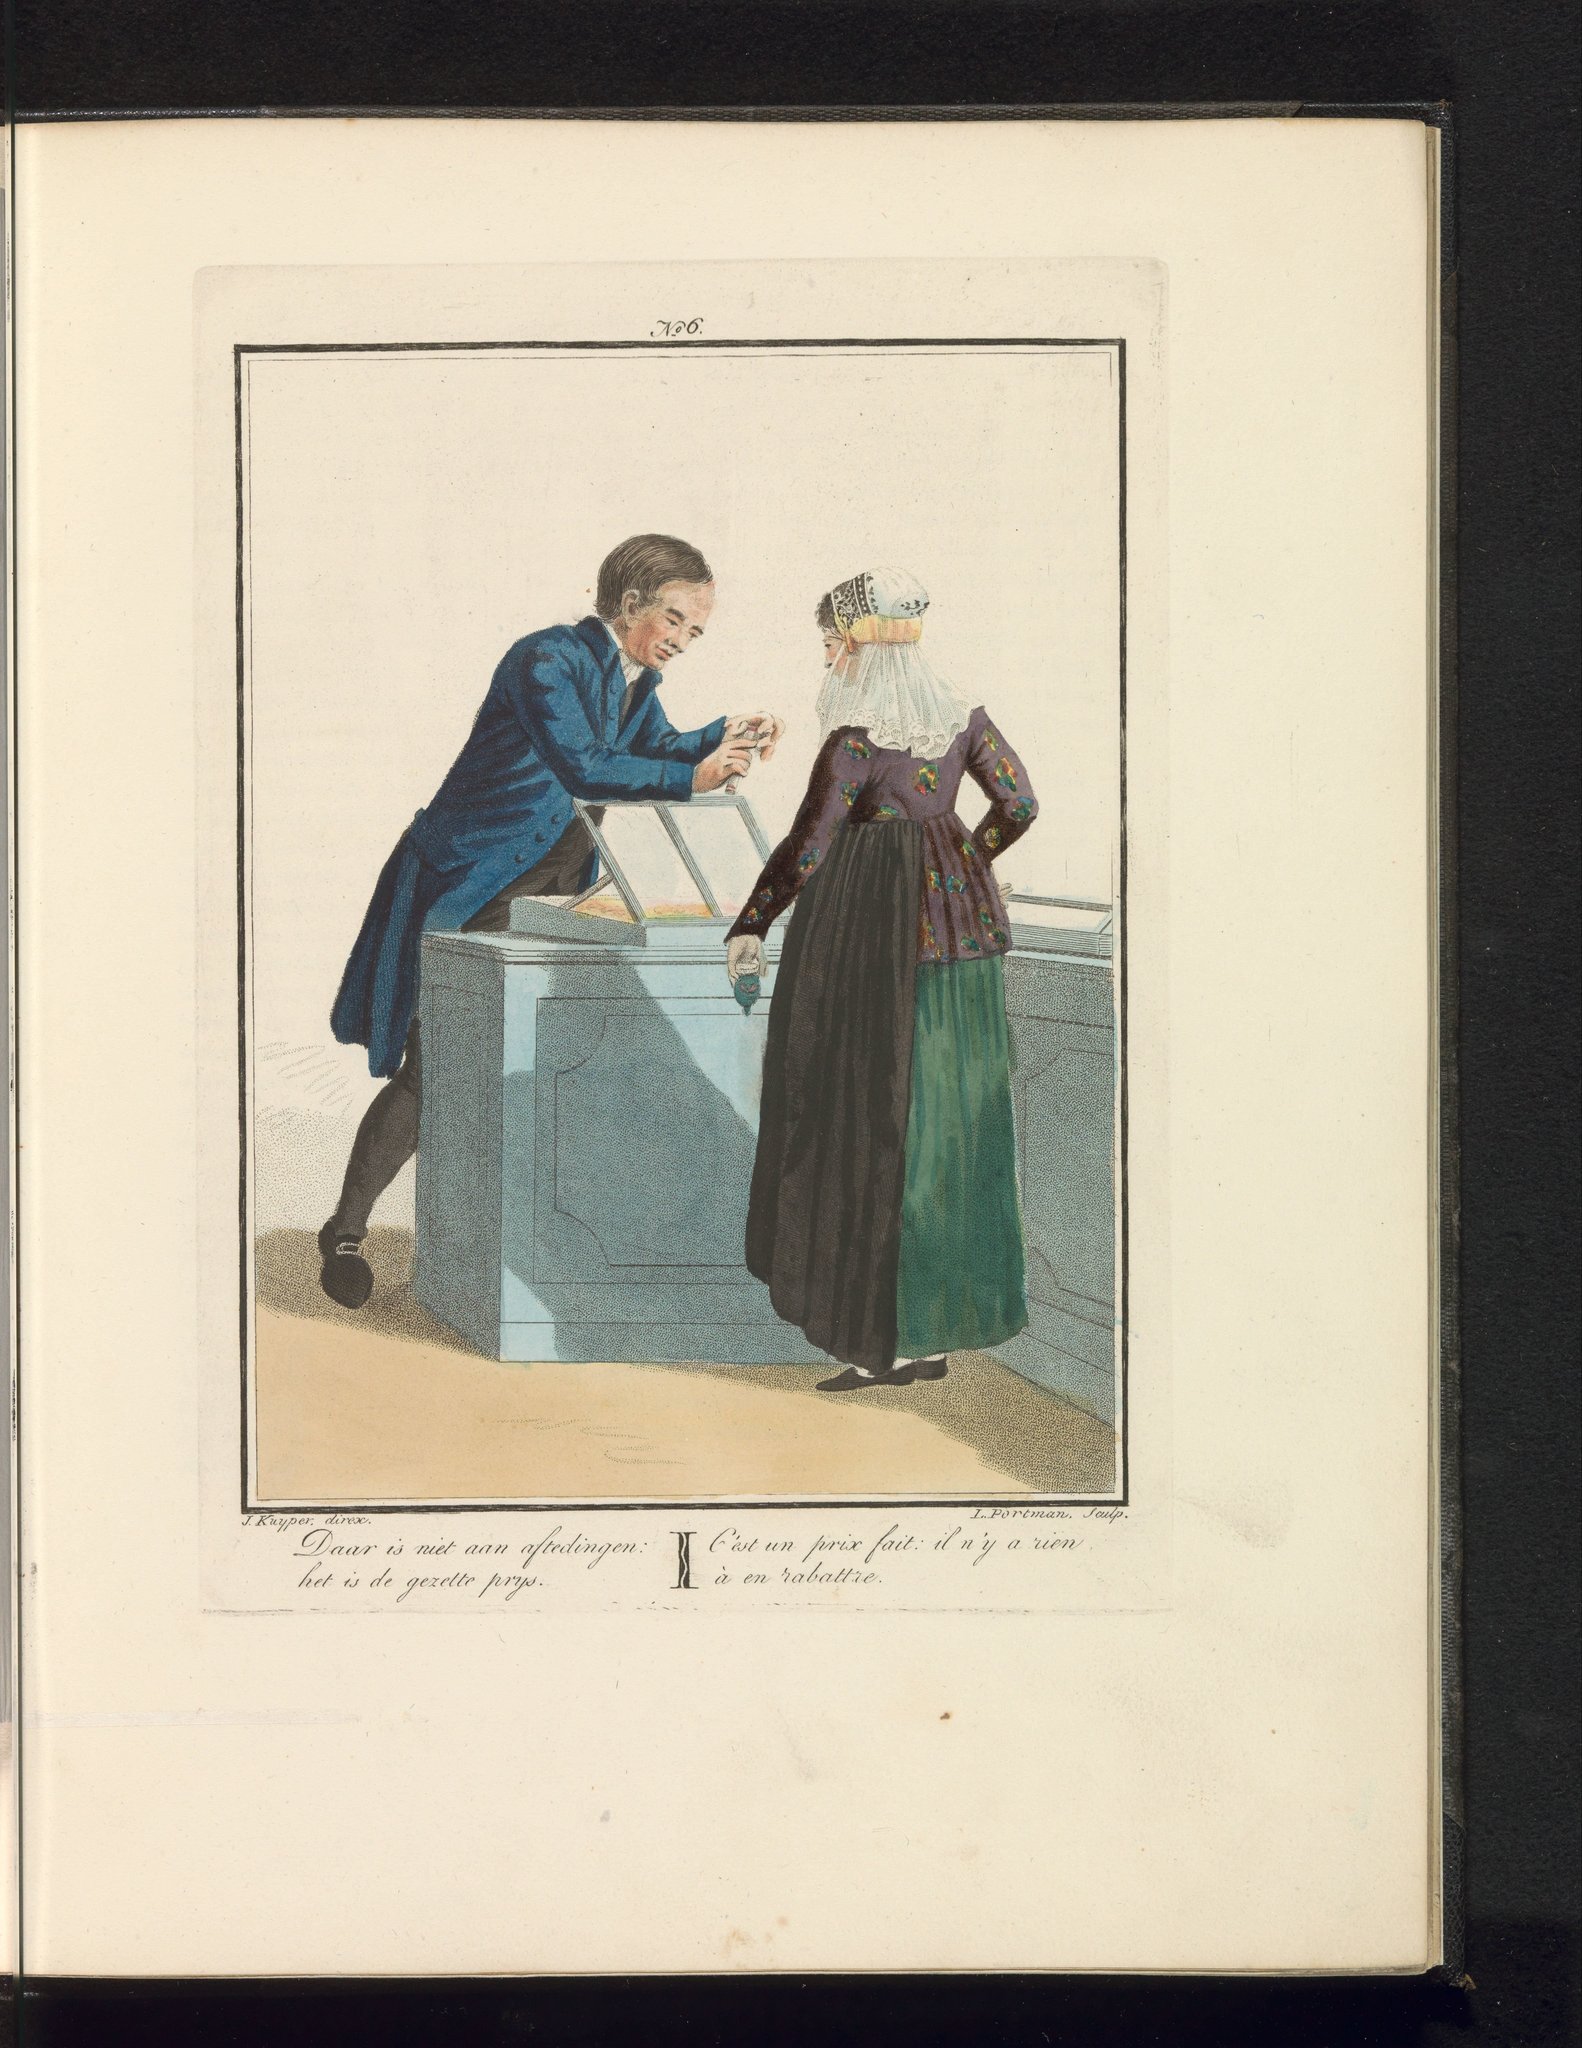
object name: costume print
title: Daar is niet aan aftedingen: het is de gezette prys / C'est un prix fait: il n'y a rien à en rabattre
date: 1804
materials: paper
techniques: etching, hand coloring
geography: netherlands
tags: shop, store, clothes, costume, zeist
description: Gebruikt als illustratie in: Evert Maaskamp, Afbeeldingen van de kleedingen, zeden en gewoonten in de noordelijke provincien van het Koningrijk der Nederlanden, met den aanvang der negentiende eeuw = Tableaux des habillemens, mœurs et coutumes dans les provinces septentrionales du Royaume des Pays-Bas, au commencement du dix-neuvième siècle. Amsterdam: Evert Maaskamp, 1829 [heruitgave van de oorspronkelijke platen eerst verschenen in 1803-1807].